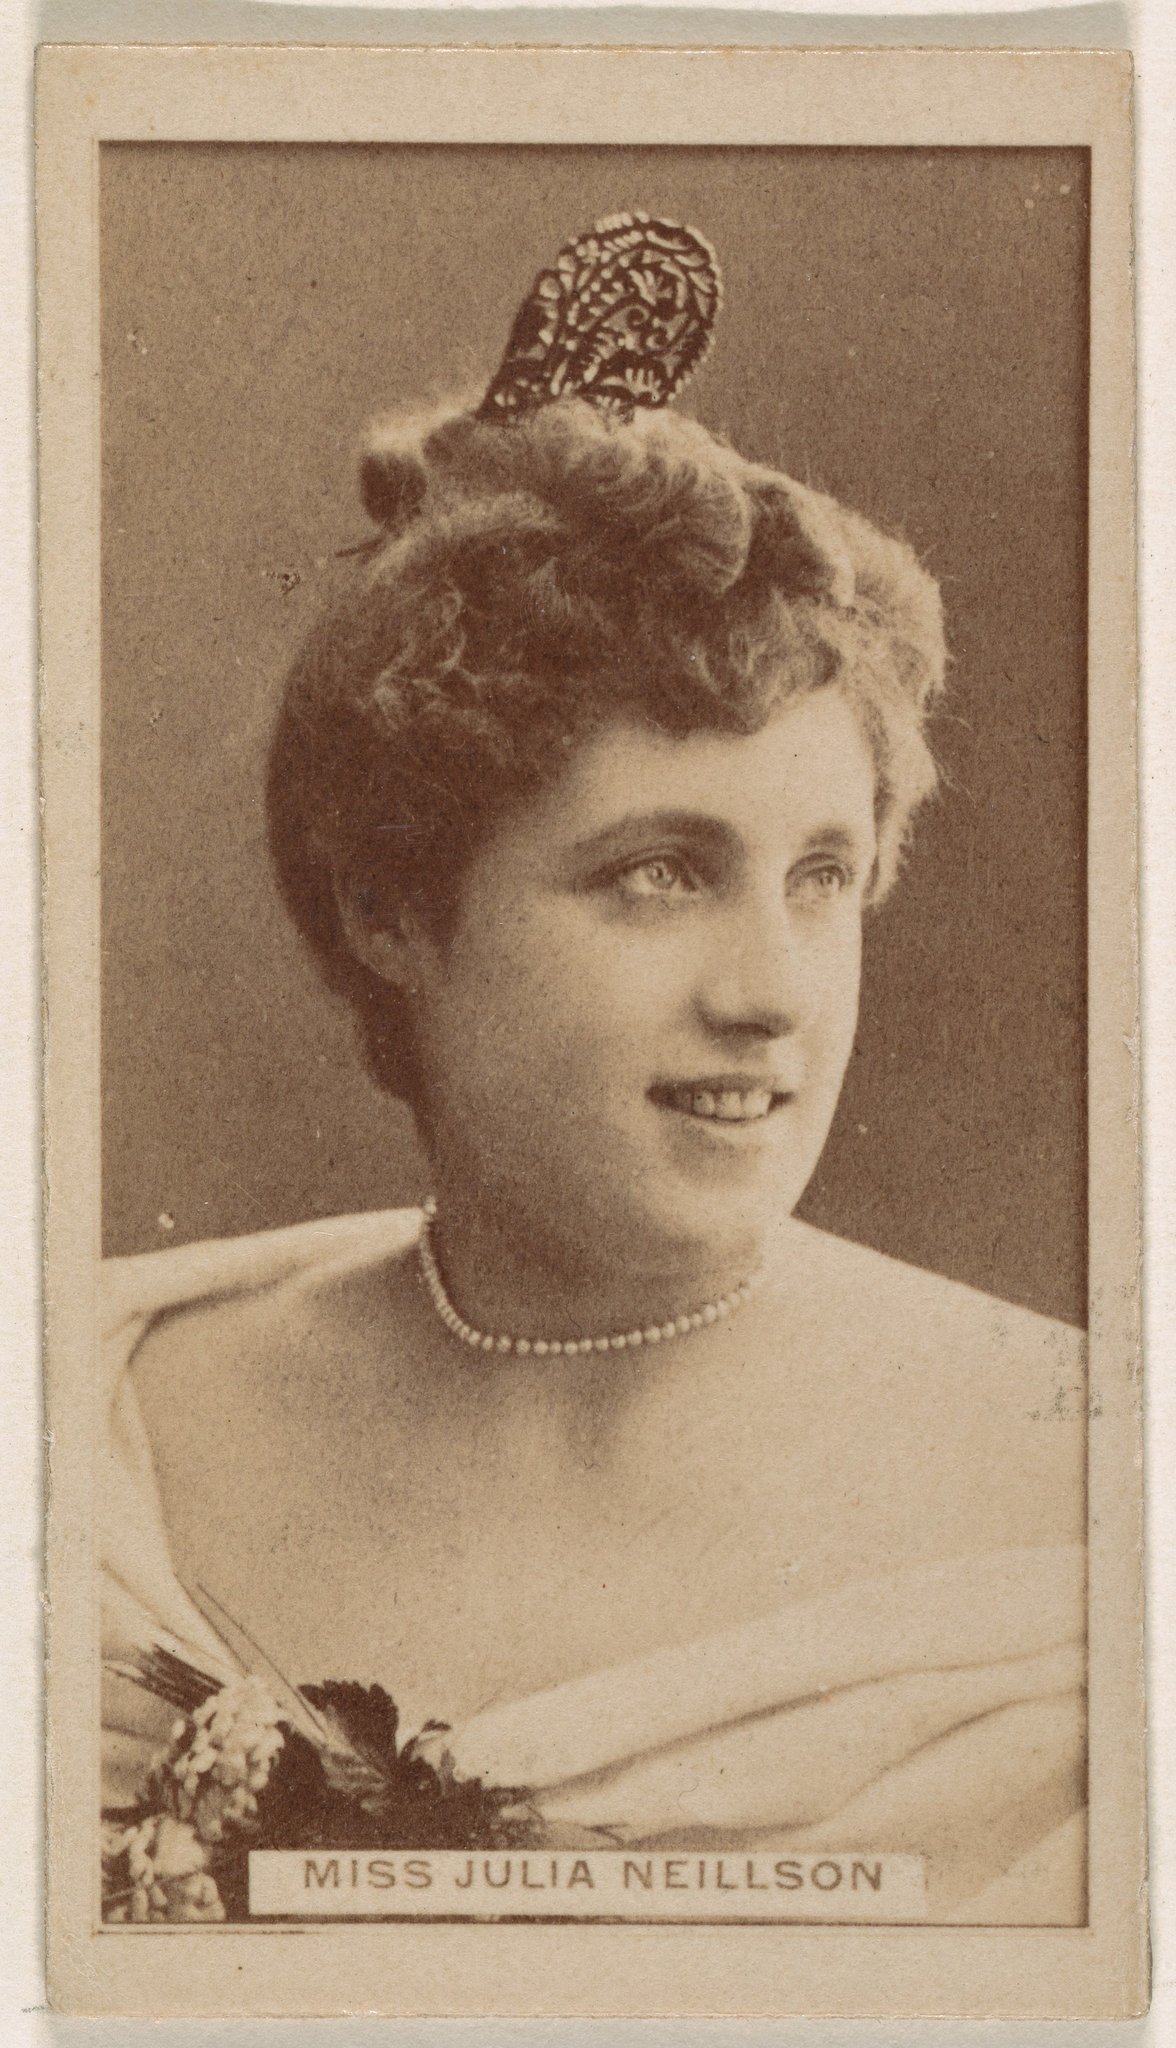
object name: photograph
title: Miss Julia Neillson, from the Actresses series (N245) issued by Kinney Brothers to promote Sweet Caporal Cigarettes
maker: kinney brothers tobacco company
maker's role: publisher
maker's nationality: american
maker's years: 1869-2011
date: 1890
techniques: albumen silver print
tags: portraits,women,actresses